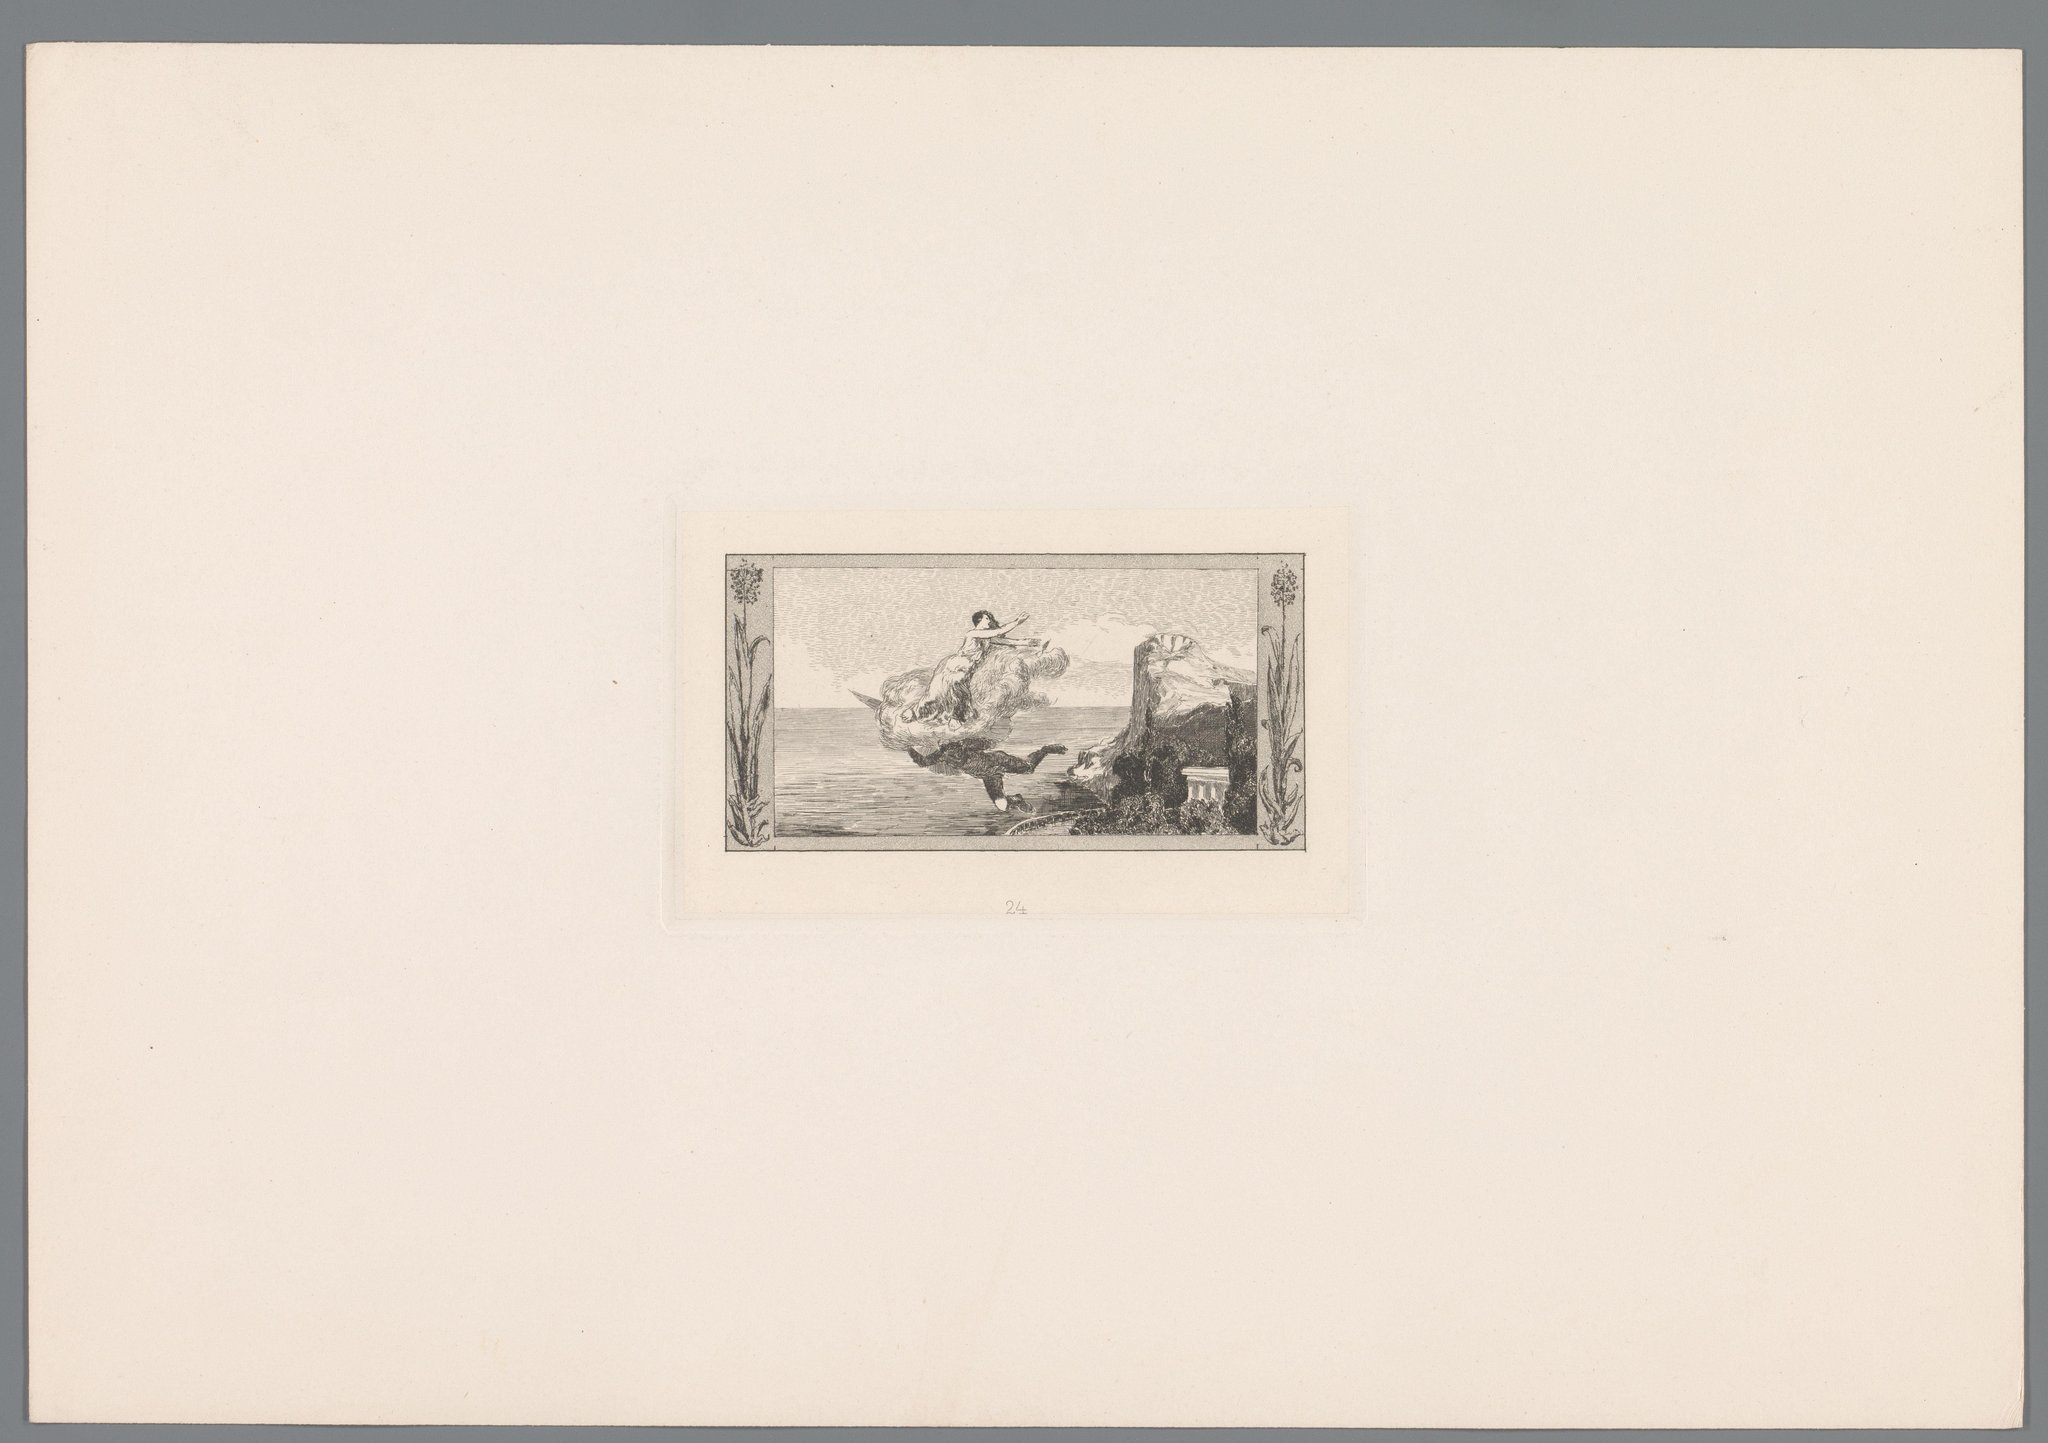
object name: print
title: Etsen bij Amor en Psyche van Apuleius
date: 1880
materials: paper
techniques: aquatint, etching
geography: nuremberg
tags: zephyrus carries psyche away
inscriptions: collector's mark: Lugt 2228